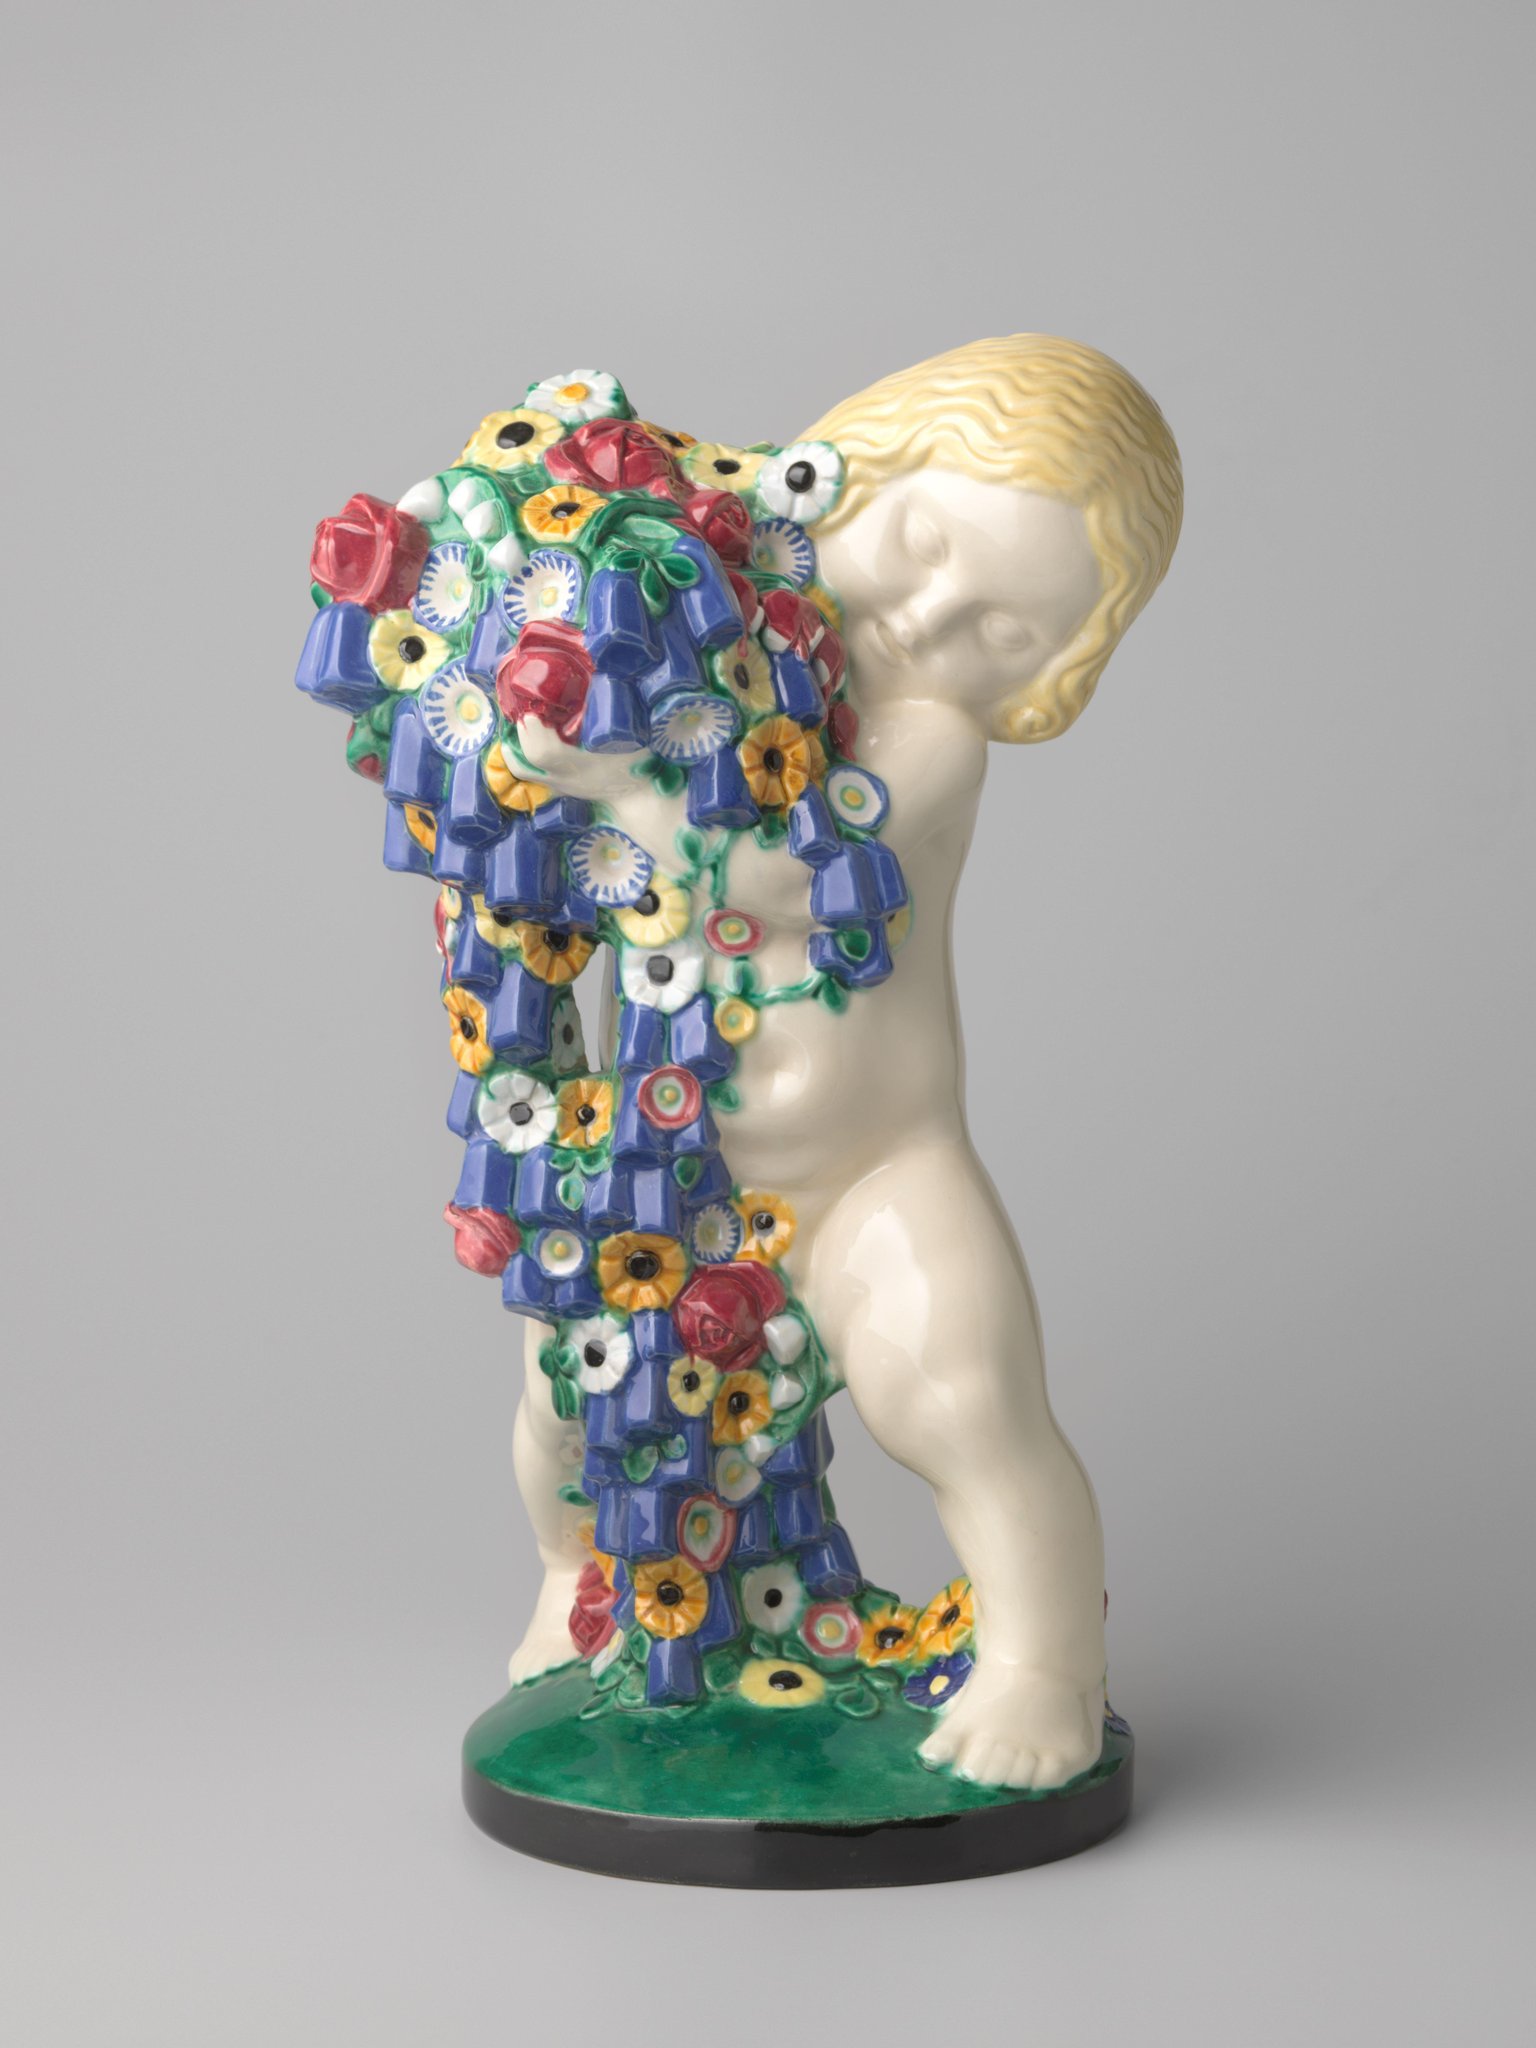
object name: putto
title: Putto met bloemenguirlande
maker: michael powolny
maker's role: sculptor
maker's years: 1871-1954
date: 1912-1925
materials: earthenware, glaze, chemical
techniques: firing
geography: gmunden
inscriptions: mark: ‘bloem in pot tussen de letters G en K binnen vierkant en het nr. 60’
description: Putto. Earthenware. Gmunden, c. 1915, made by Vereinigte Wiener und Gmundner Keramik, designed by Michael Powolny c. 1908.